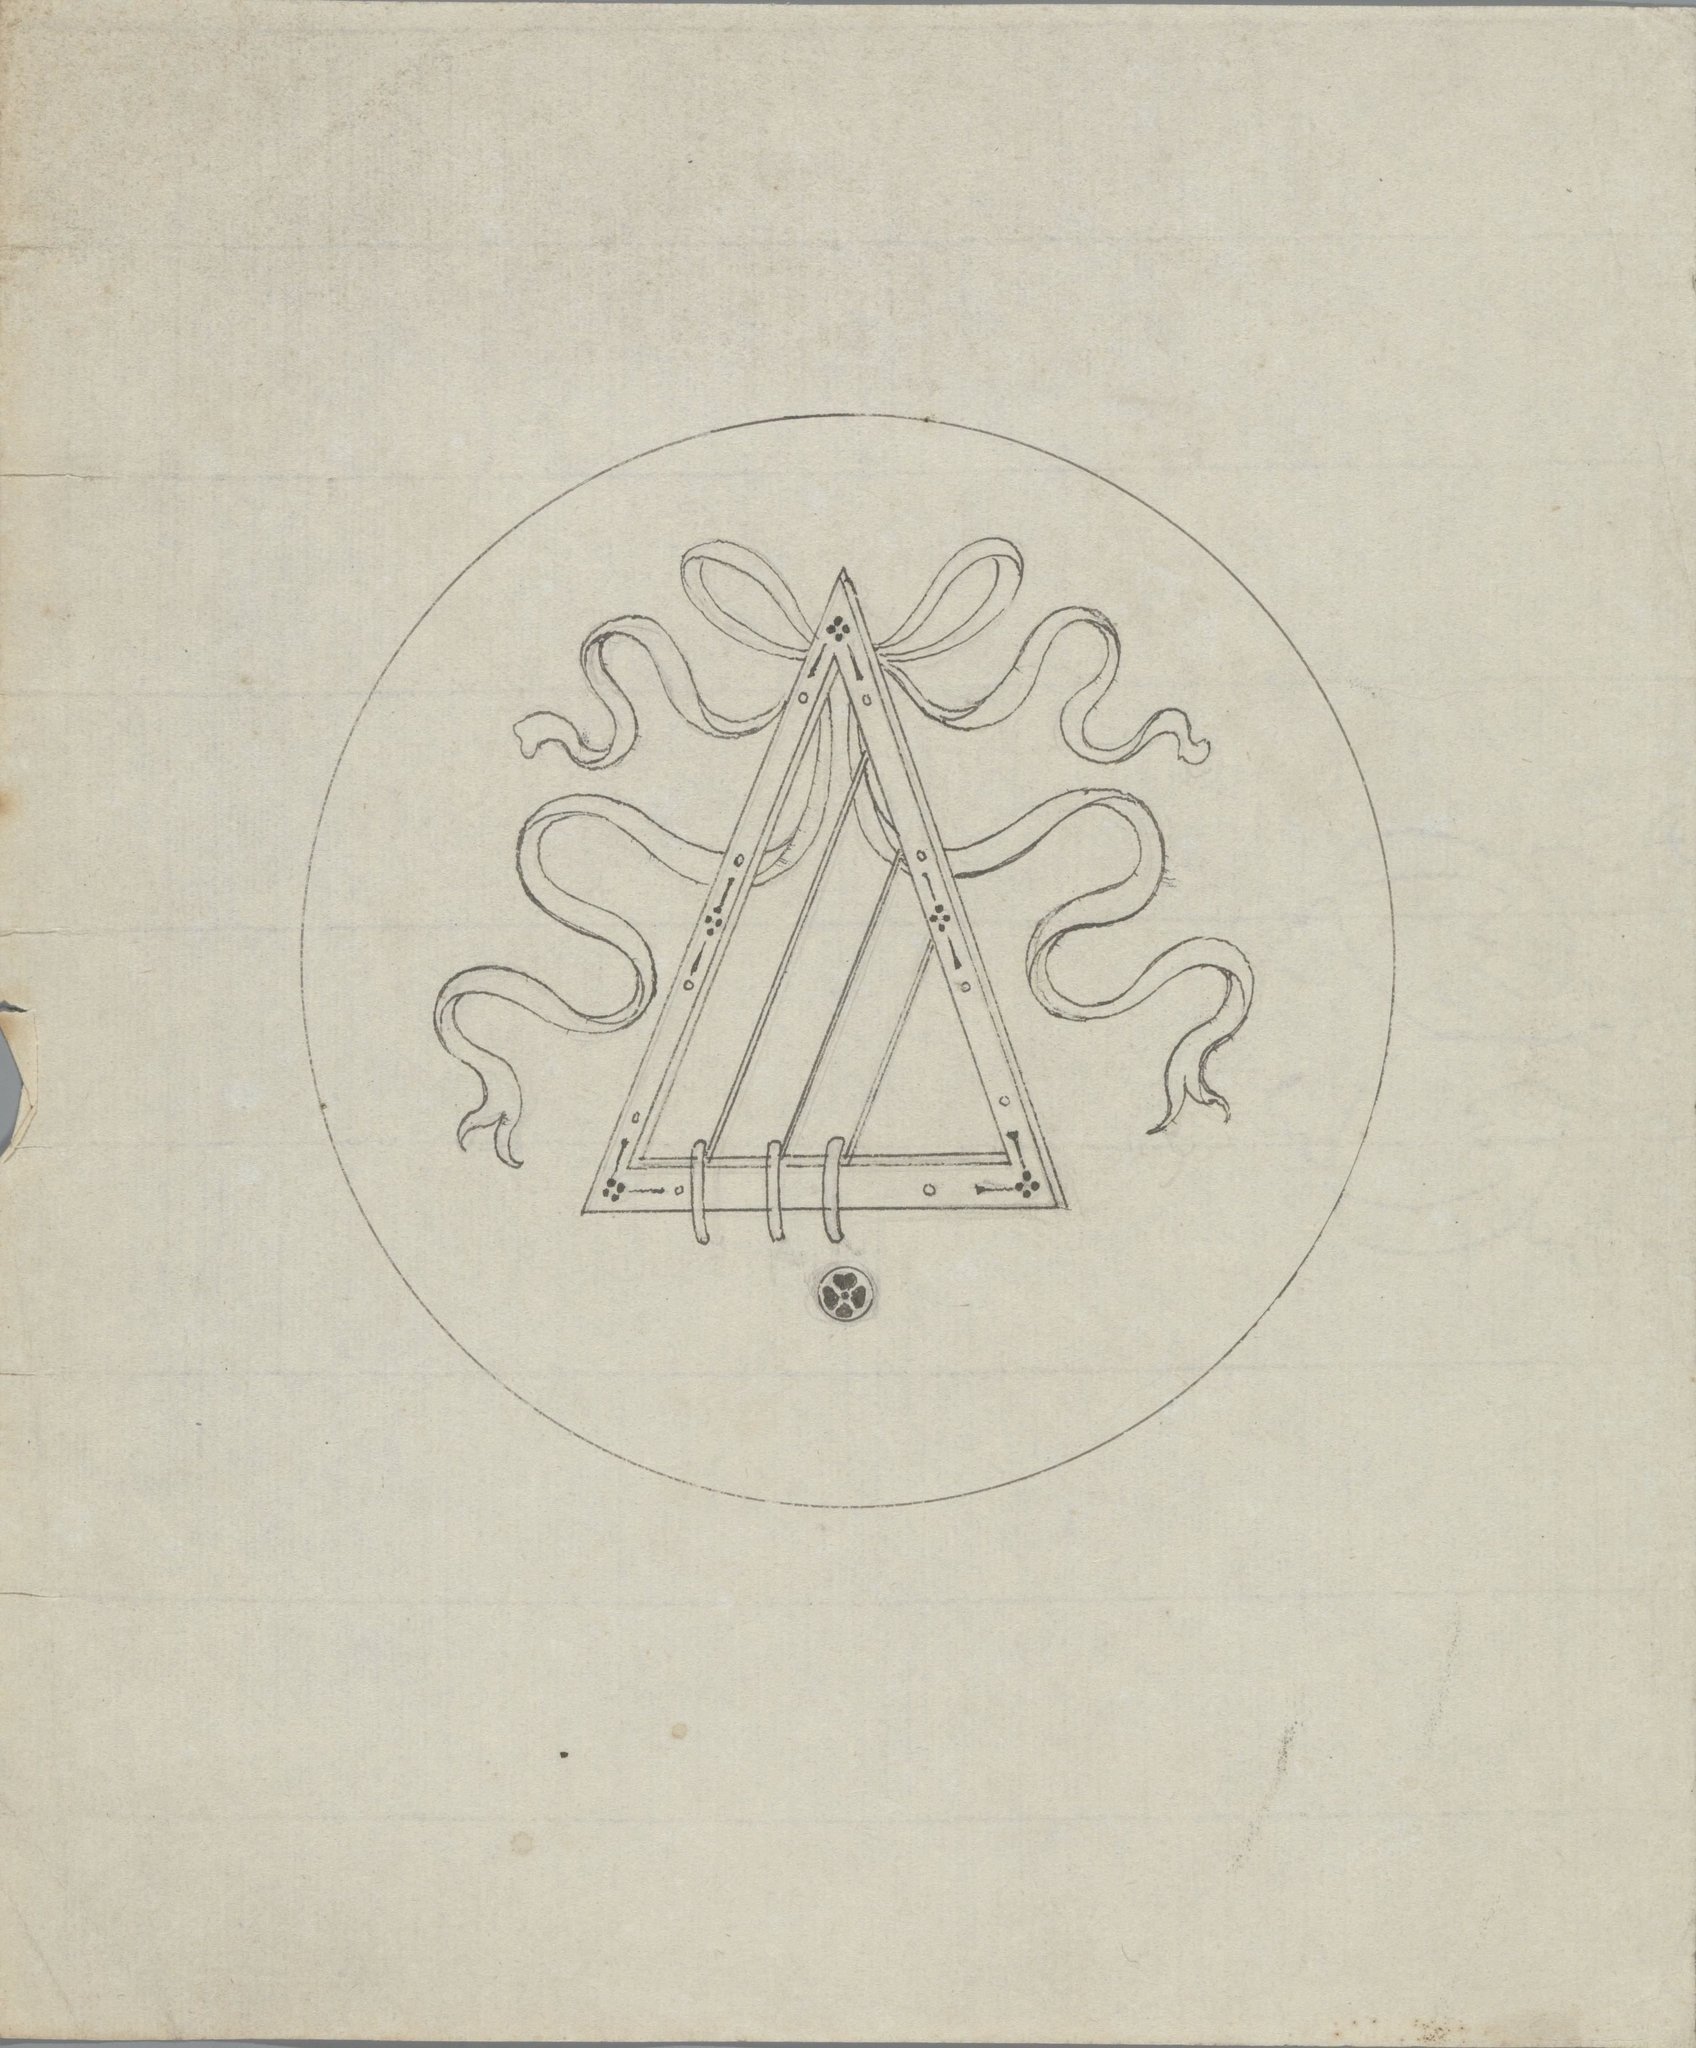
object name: design drawing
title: Driehoekig snaarinstrument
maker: pierre félix van doren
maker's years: 1797-1856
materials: graphite, ink, paper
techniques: pen in black ink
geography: brussels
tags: trophy, i.e.: decorative arrangement of symbolic or typical objects ~ ornament, string instruments (plucked)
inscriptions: watermark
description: Een van 103 ontwerpen voor marqueterie van aan linten opgehangen muziekinstrumenten in ronde medaillons, bestemd voor de set stoelen gemaakt door Van Doren voor de grote zaal van het Paleis van de Prins van Oranje in Brussel in 1828.